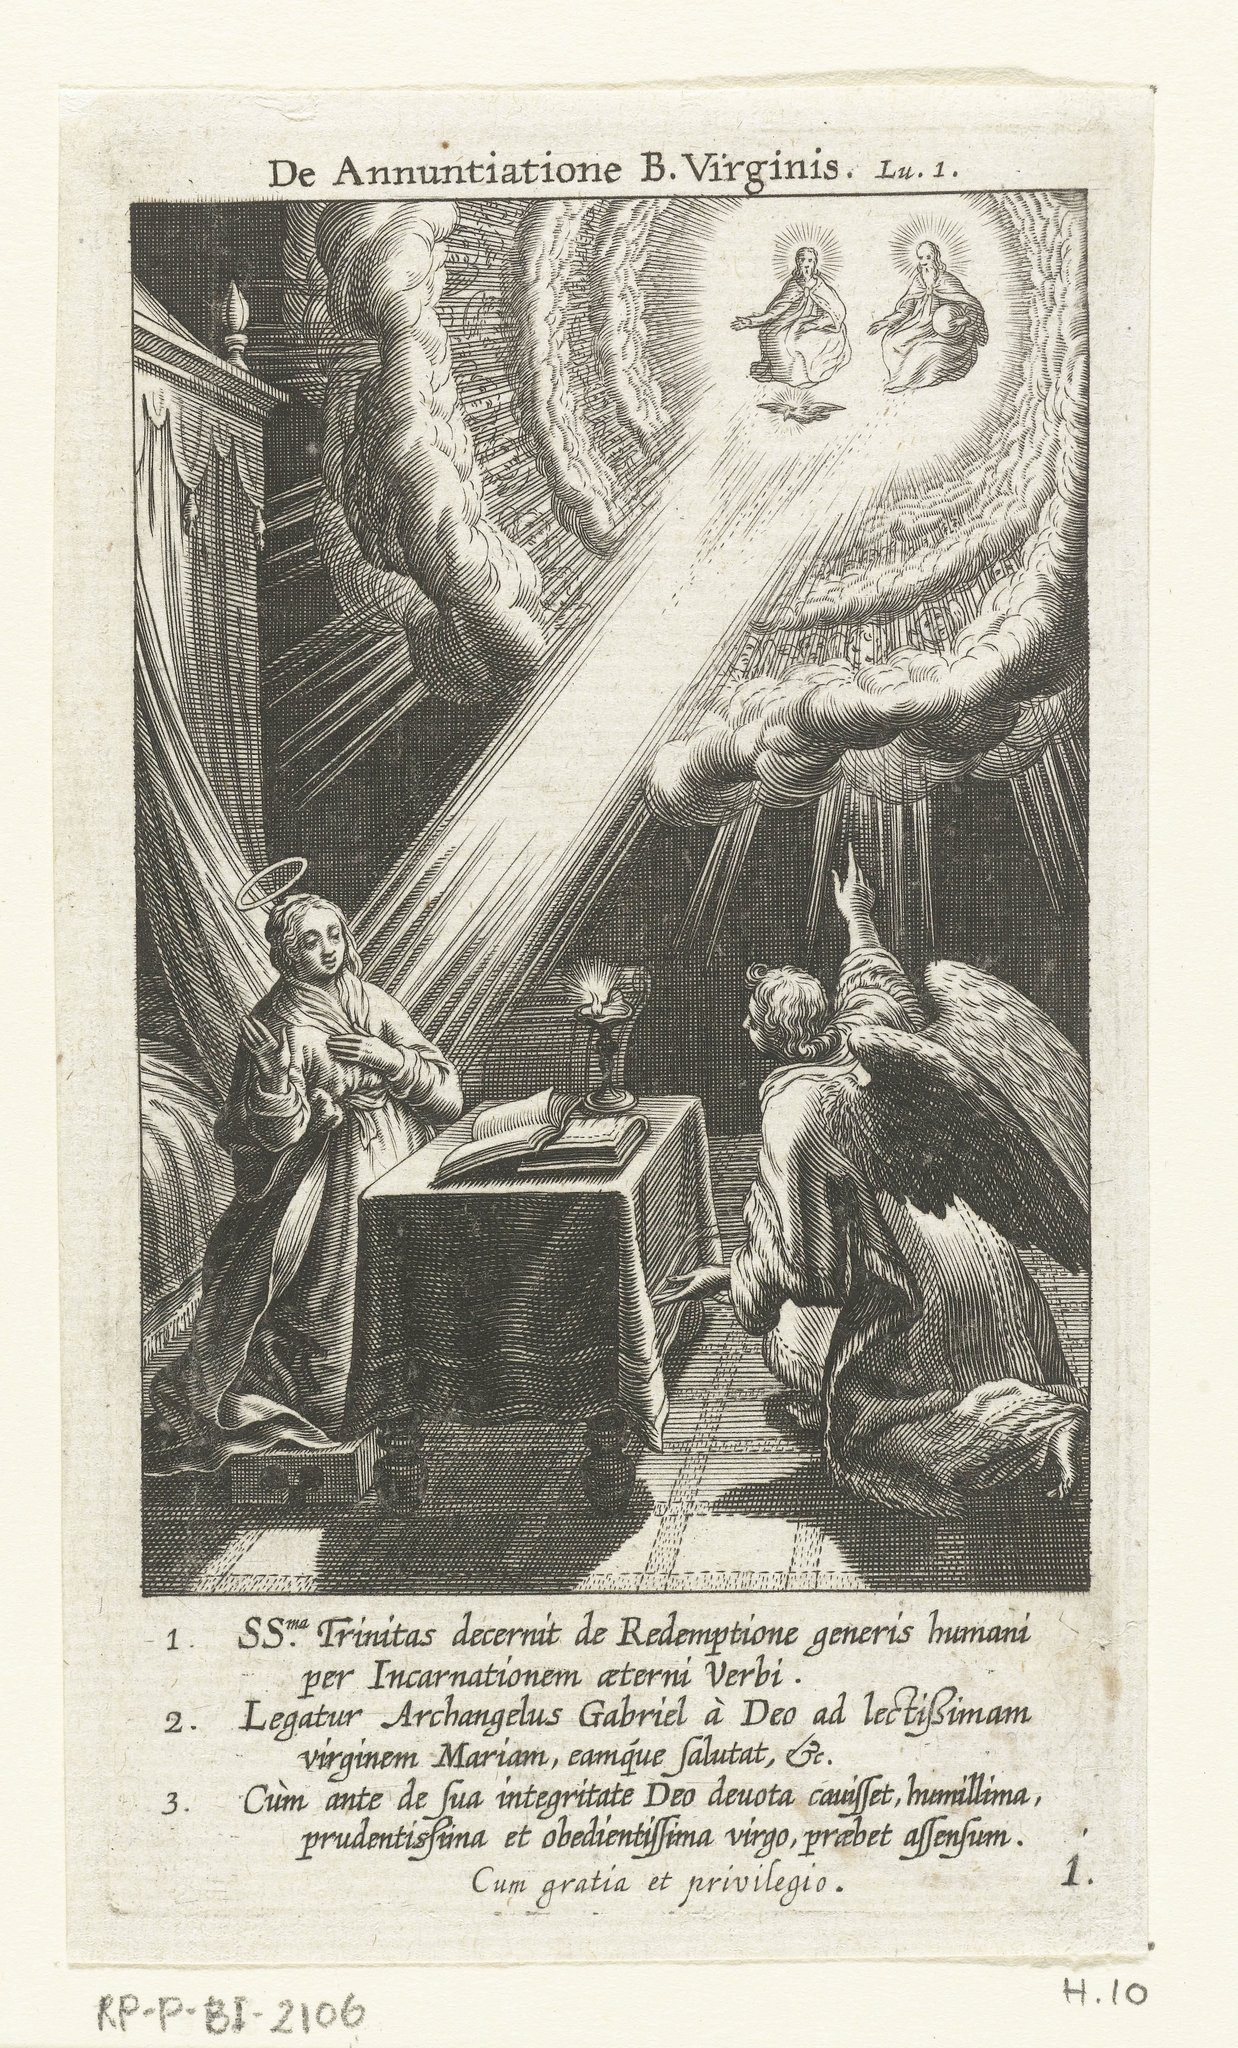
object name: book illustration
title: De Annuntiatione B. Virginis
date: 1590-1622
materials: paper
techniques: engraving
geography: antwerp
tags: the annunciation: mary, usually reading, is visited by the angel (sometimes a woman overhears the conversation)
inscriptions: collector's mark: Lugt 240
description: Prent uit: Joannes Bourgois, Vitae passionis et mortis Jesu Christi Somini nostri mysteria, Antwerpen Hendrick Aertssens, 1622, afb. 1